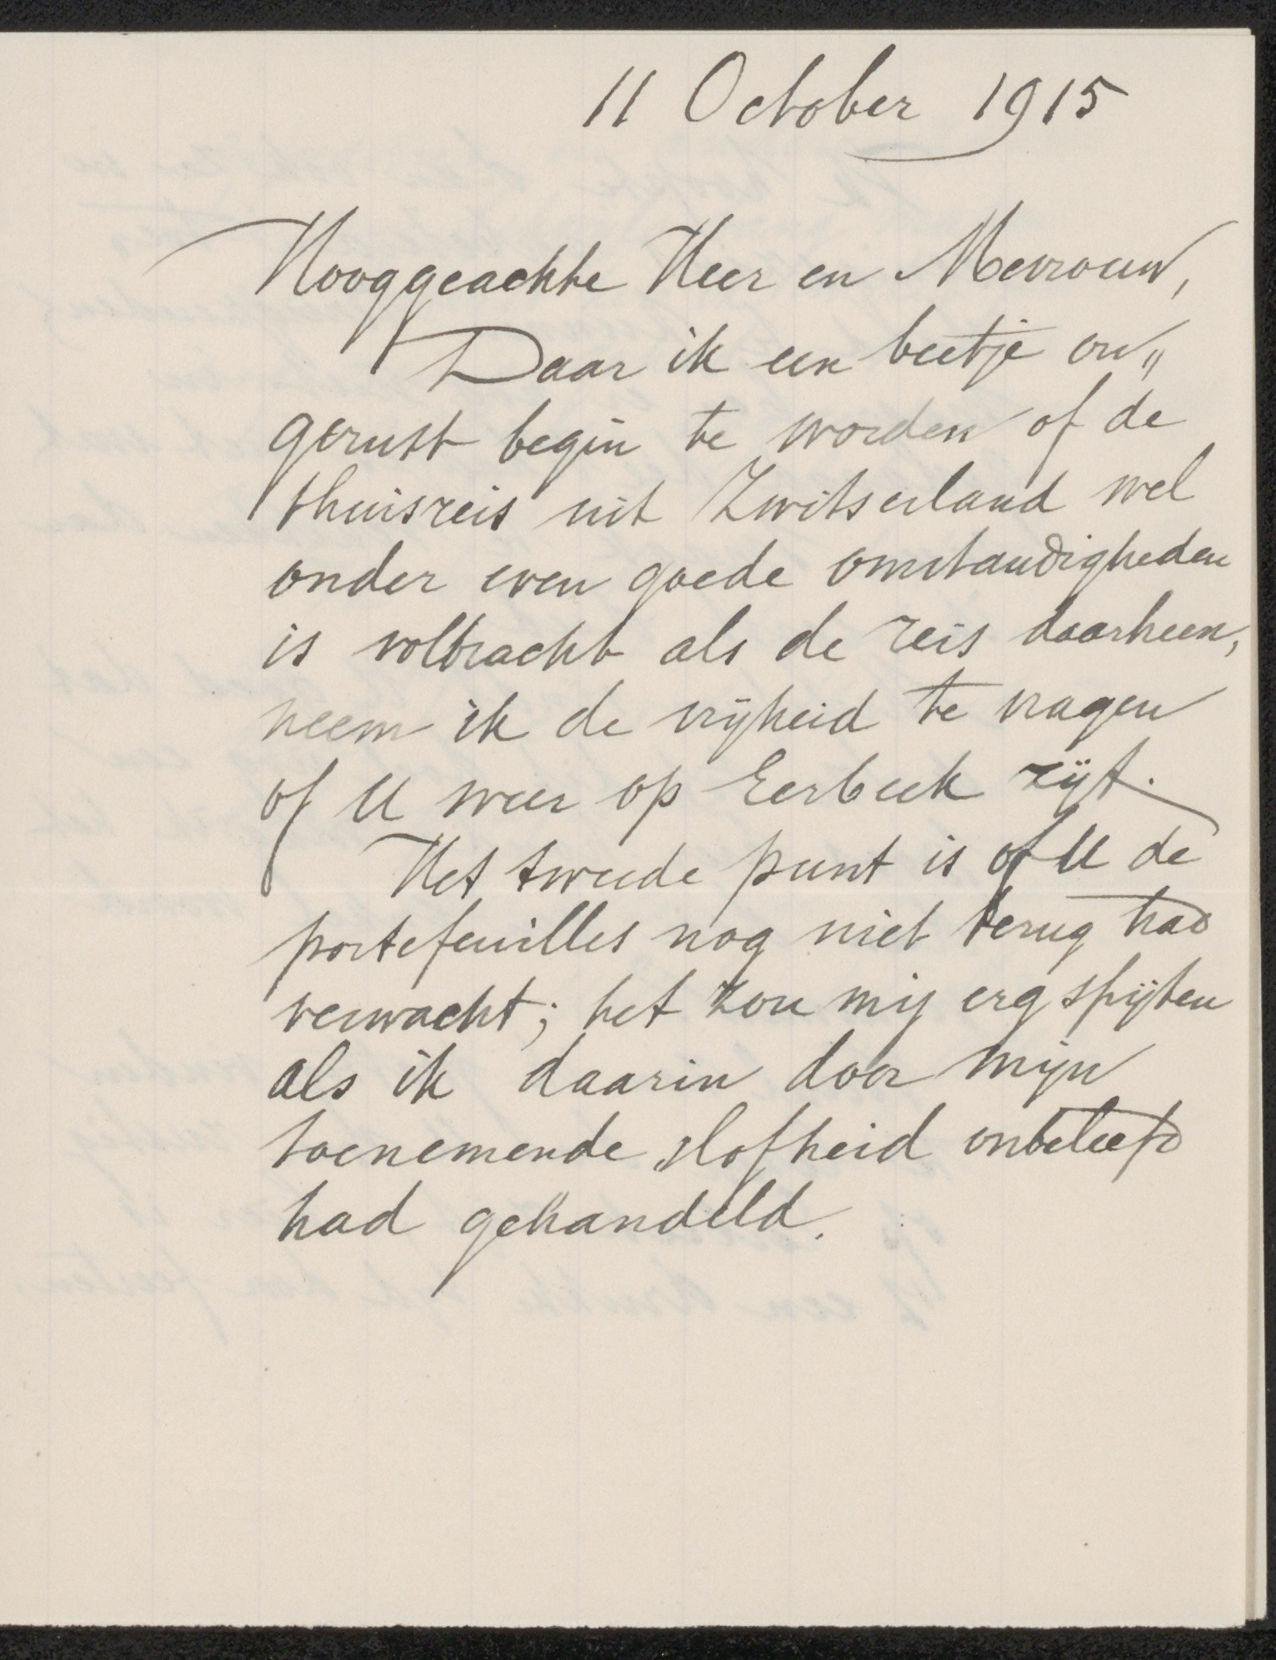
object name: letter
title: Brief aan Max Wilhelm Carl Weber en Anne Antoinette Weber-Van Bosse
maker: august allebé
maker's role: draughtsman, print maker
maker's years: 1838-1927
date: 1915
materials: ink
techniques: pen, writing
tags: amsterdam, anne antoinette weber-van bosse, museum, drawing, travelling; tourism, exhibition ~ art, switzerland